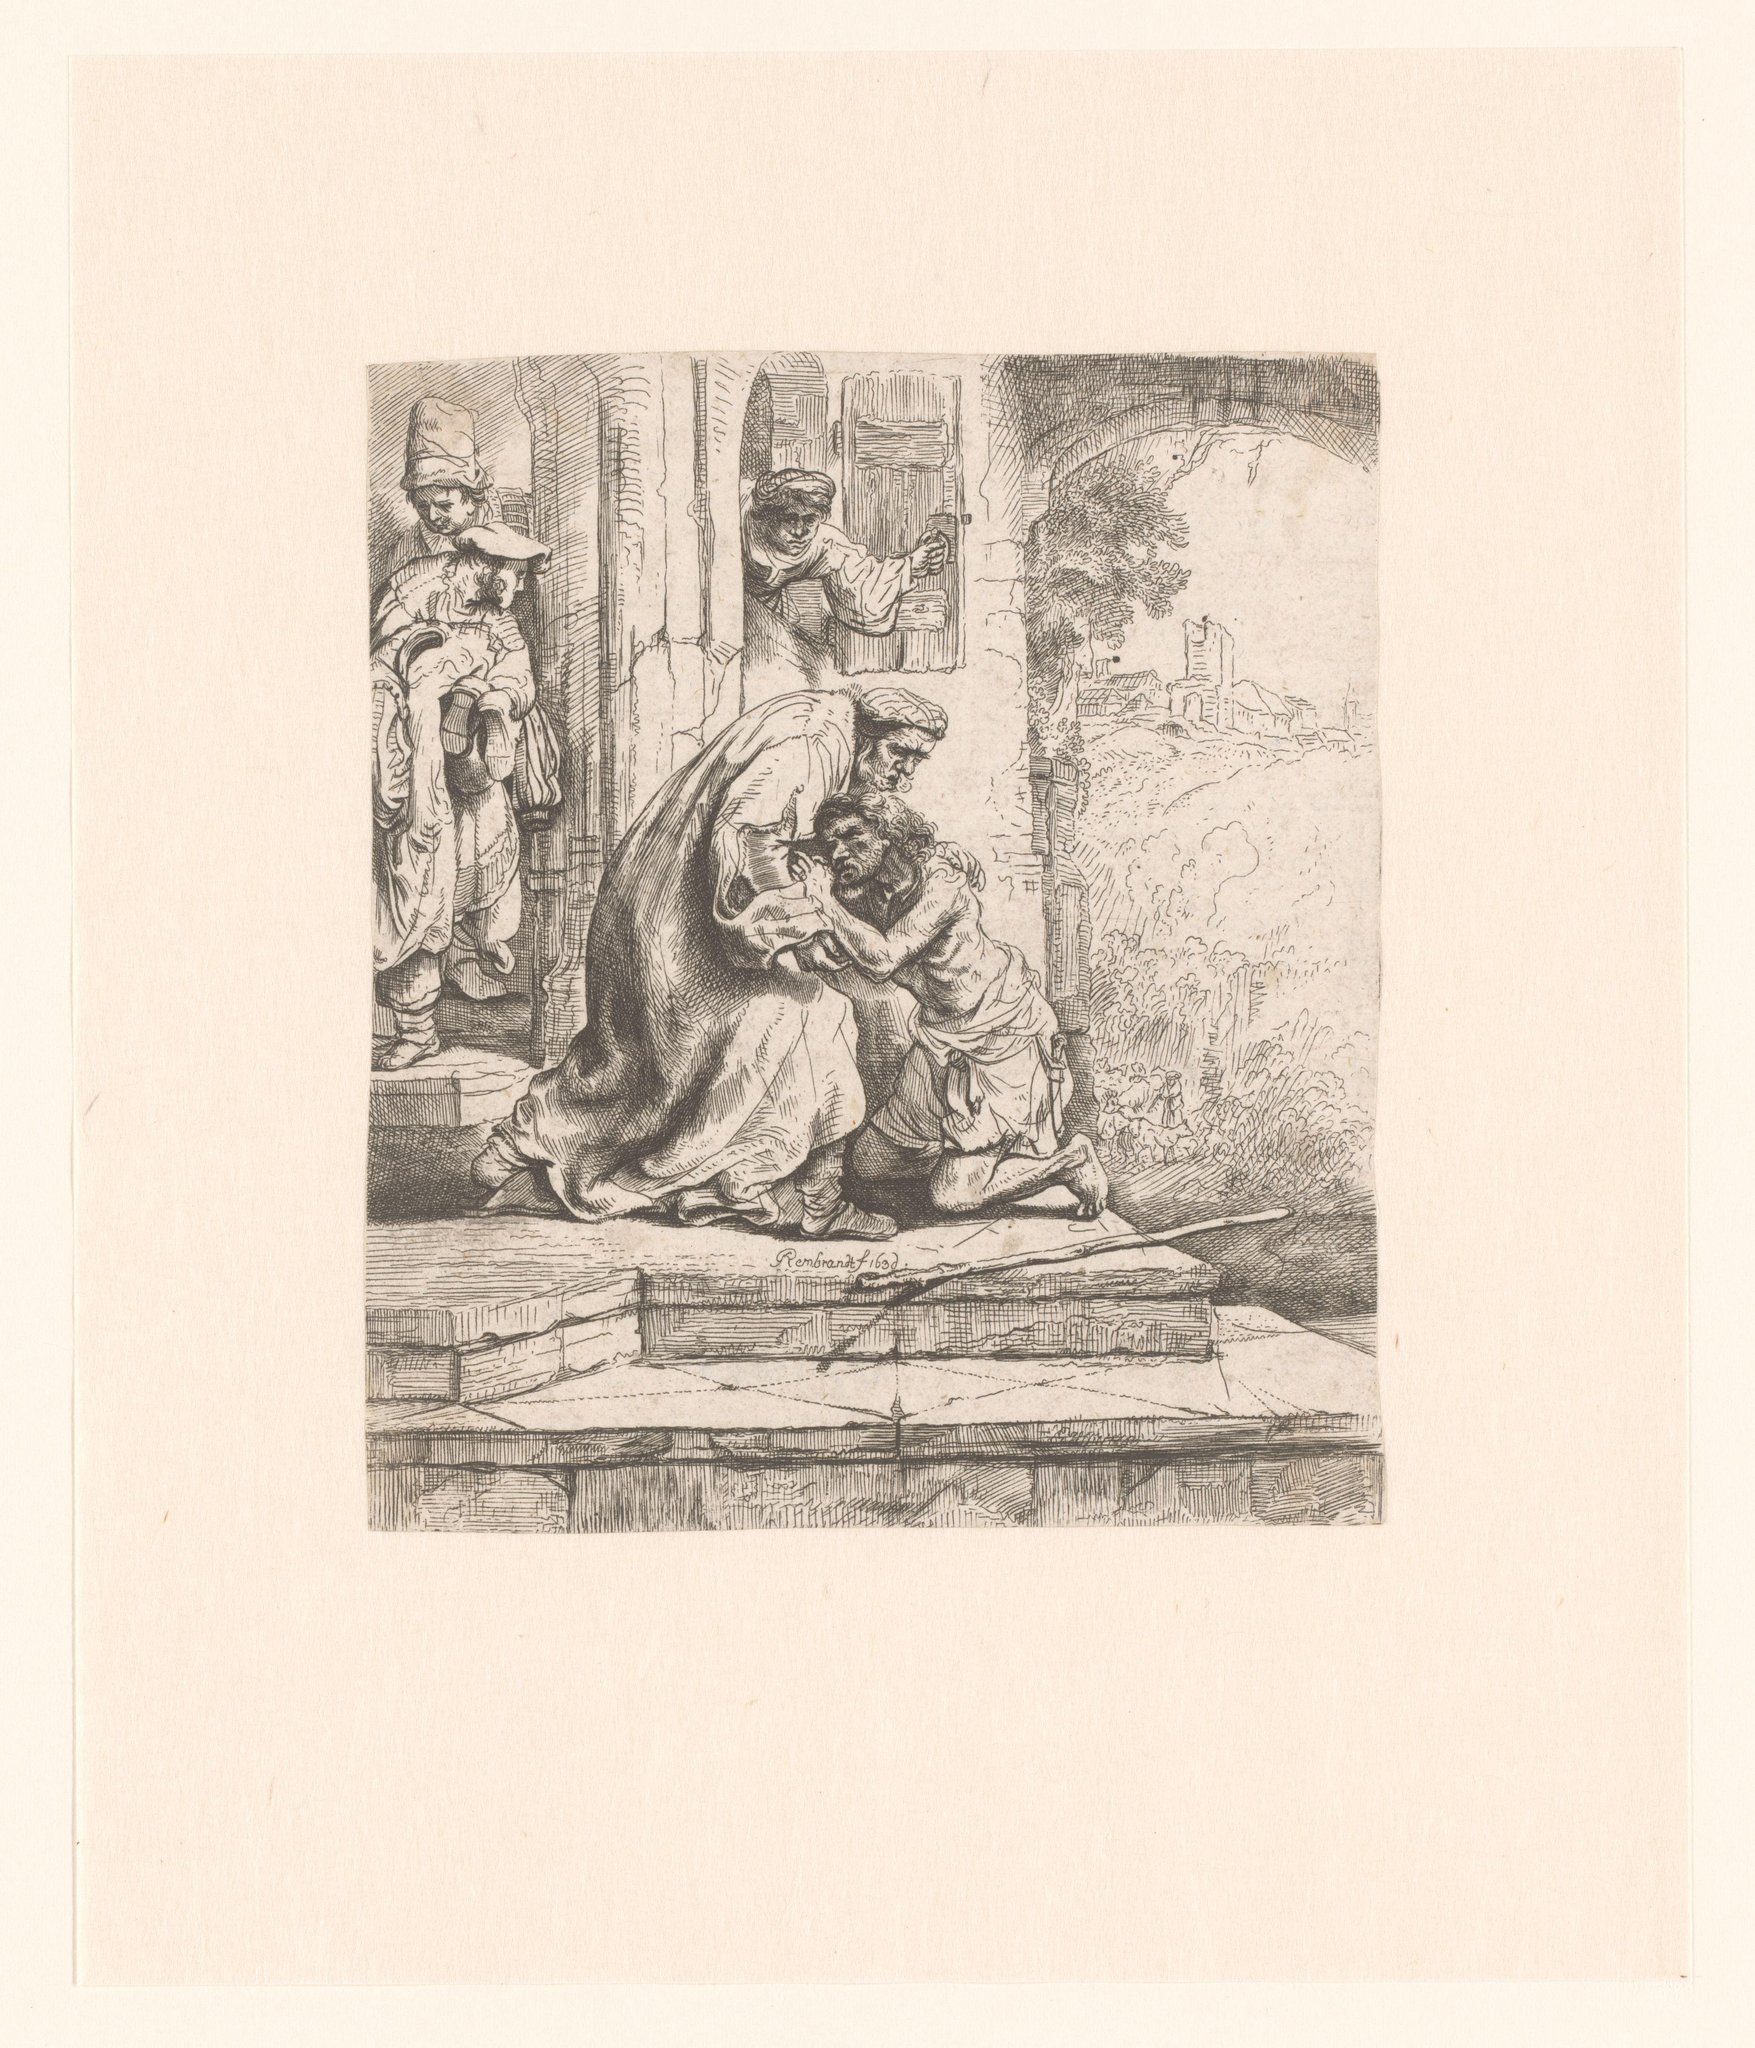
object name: print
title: The return of the prodigal son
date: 1711-1800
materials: paper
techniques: etching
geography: augsburg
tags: historical persons - bb - woman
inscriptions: collector's mark: Lugt 2228, collector's mark: Lugt 2760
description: Spiegelbeeldige kopie naar de gelijknamige prent van Rembrandt.